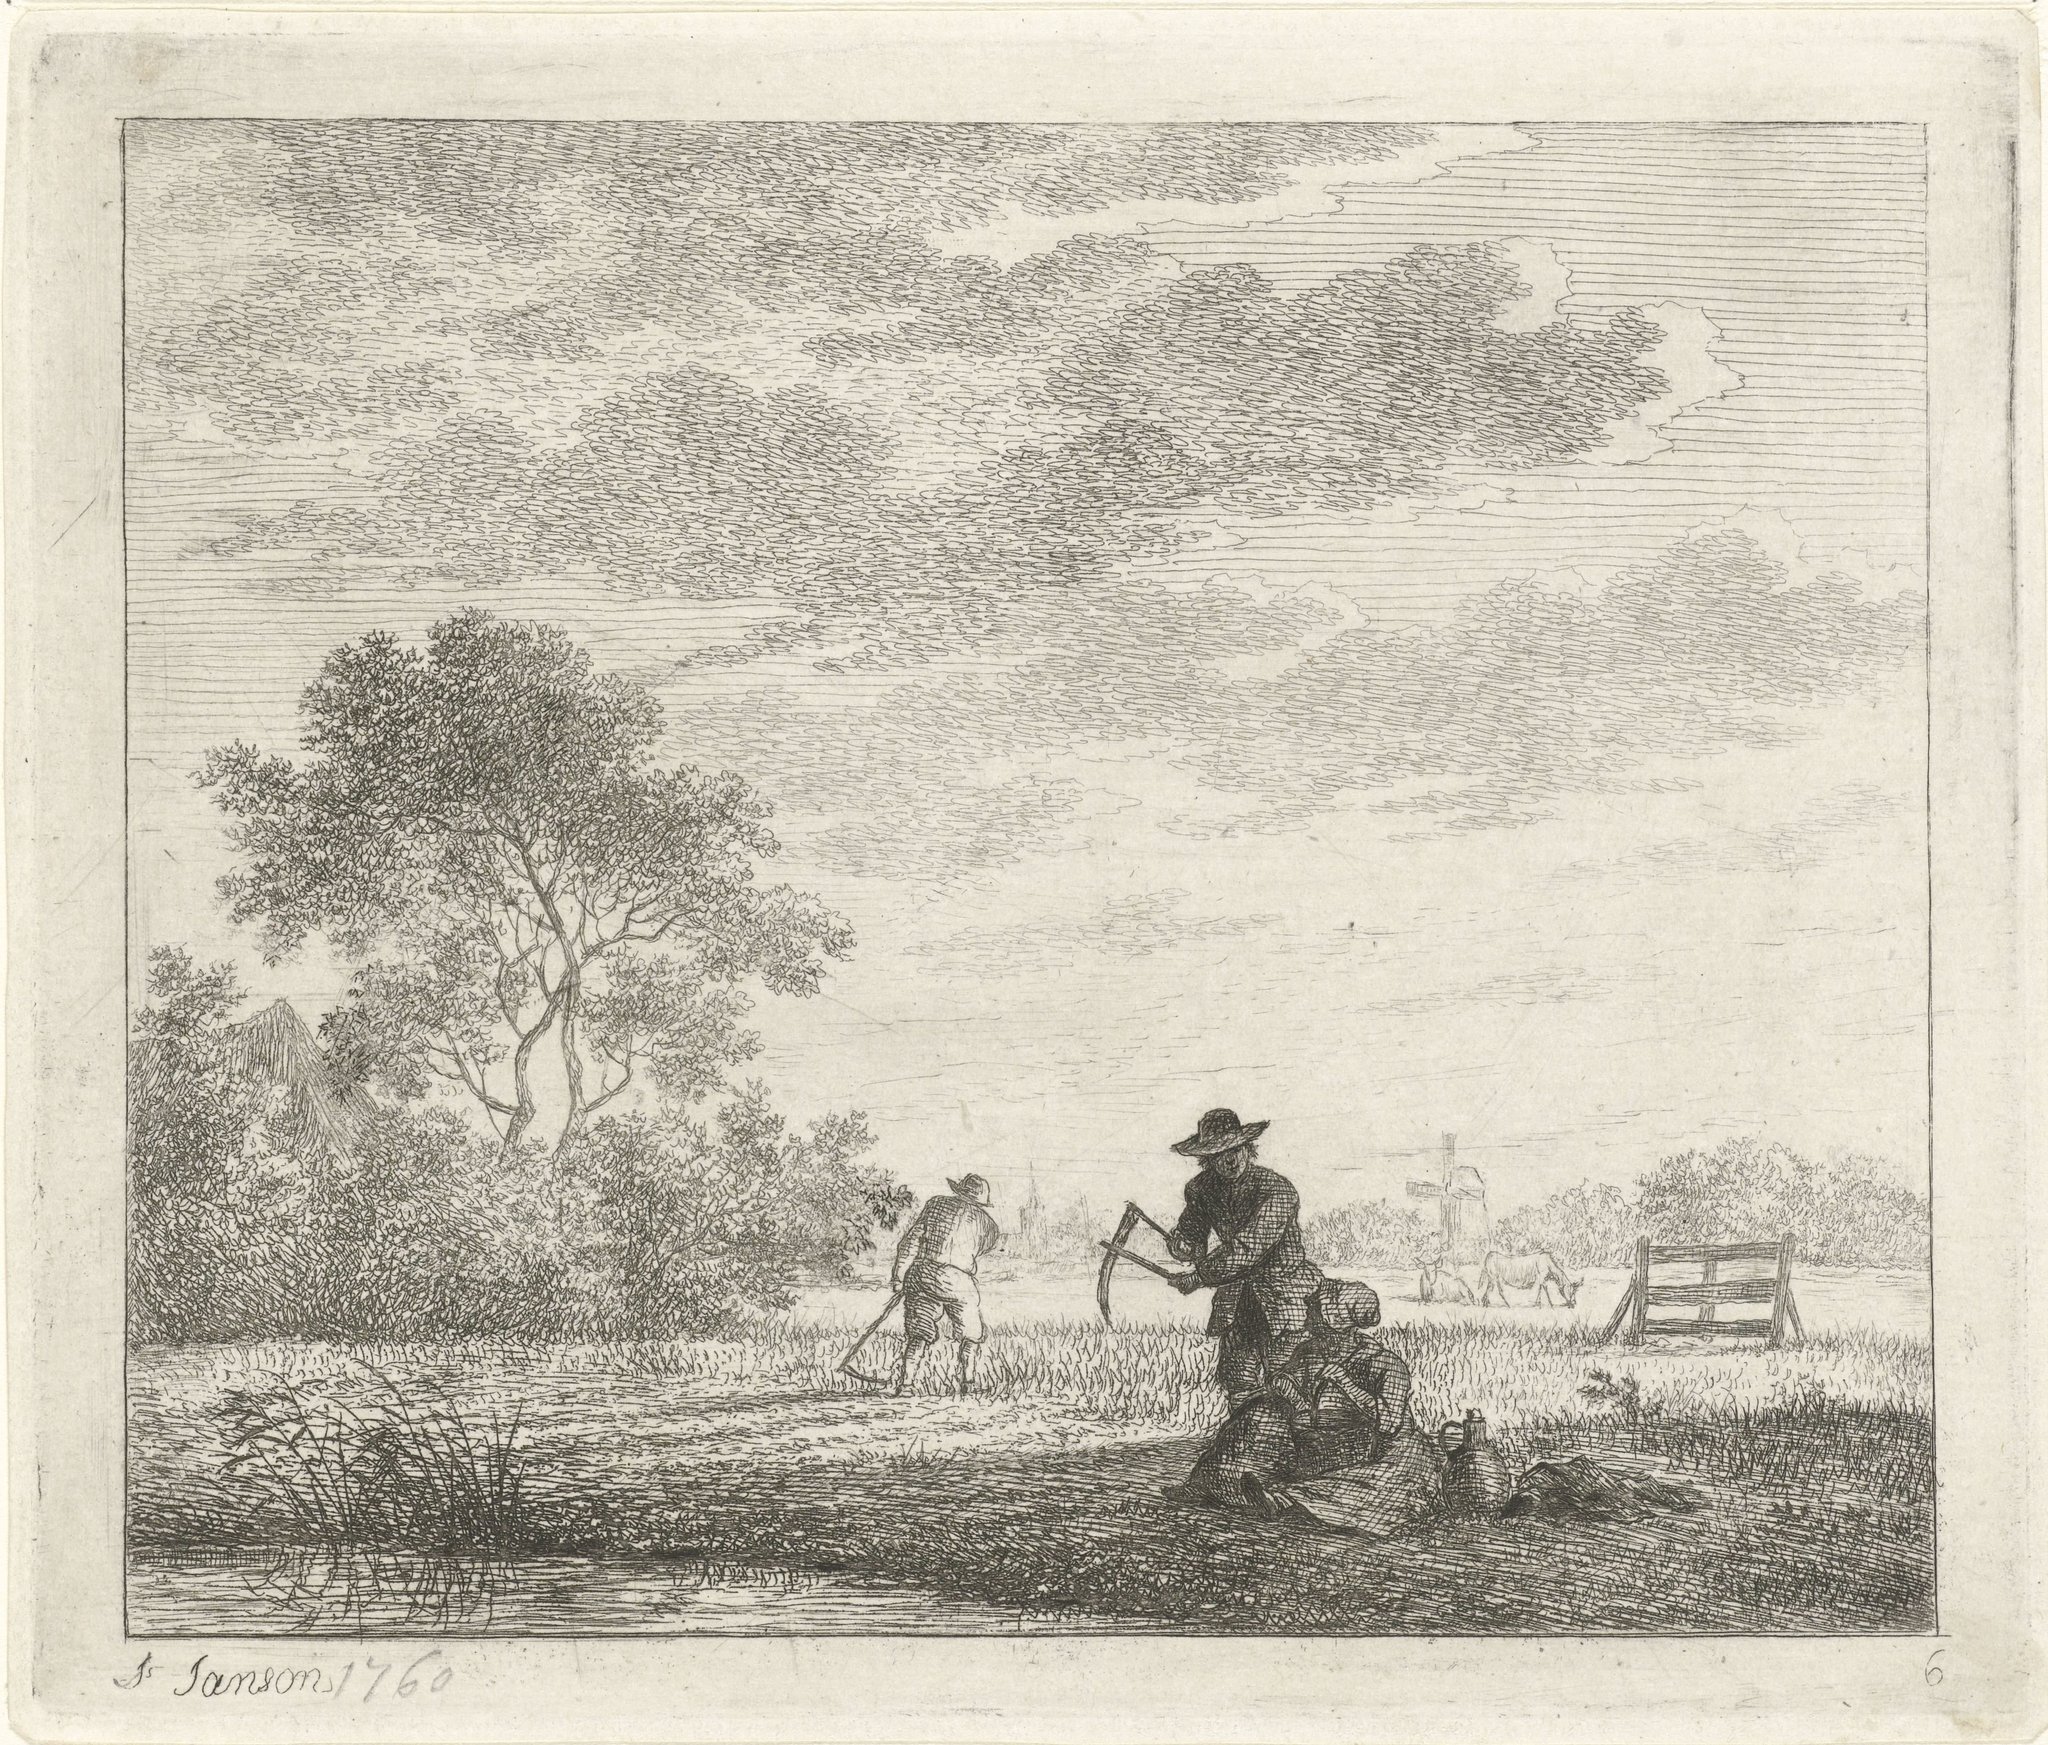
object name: print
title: Akker met boeren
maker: johannes janson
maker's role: draughtsman, painter, print maker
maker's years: 1729-1784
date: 1783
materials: paper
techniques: etching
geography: leiden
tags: agricultural implements: scythe, landscape symbolizing june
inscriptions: collector's mark: Lugt 2228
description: Landschap met een zittende boerin en twee boeren die een akker bewerken met een zeis. Op de achtergrond twee koeien, een kerk en een molen. Rechtsonder: 6. Zevende prent uit een serie van dertien met maanden.